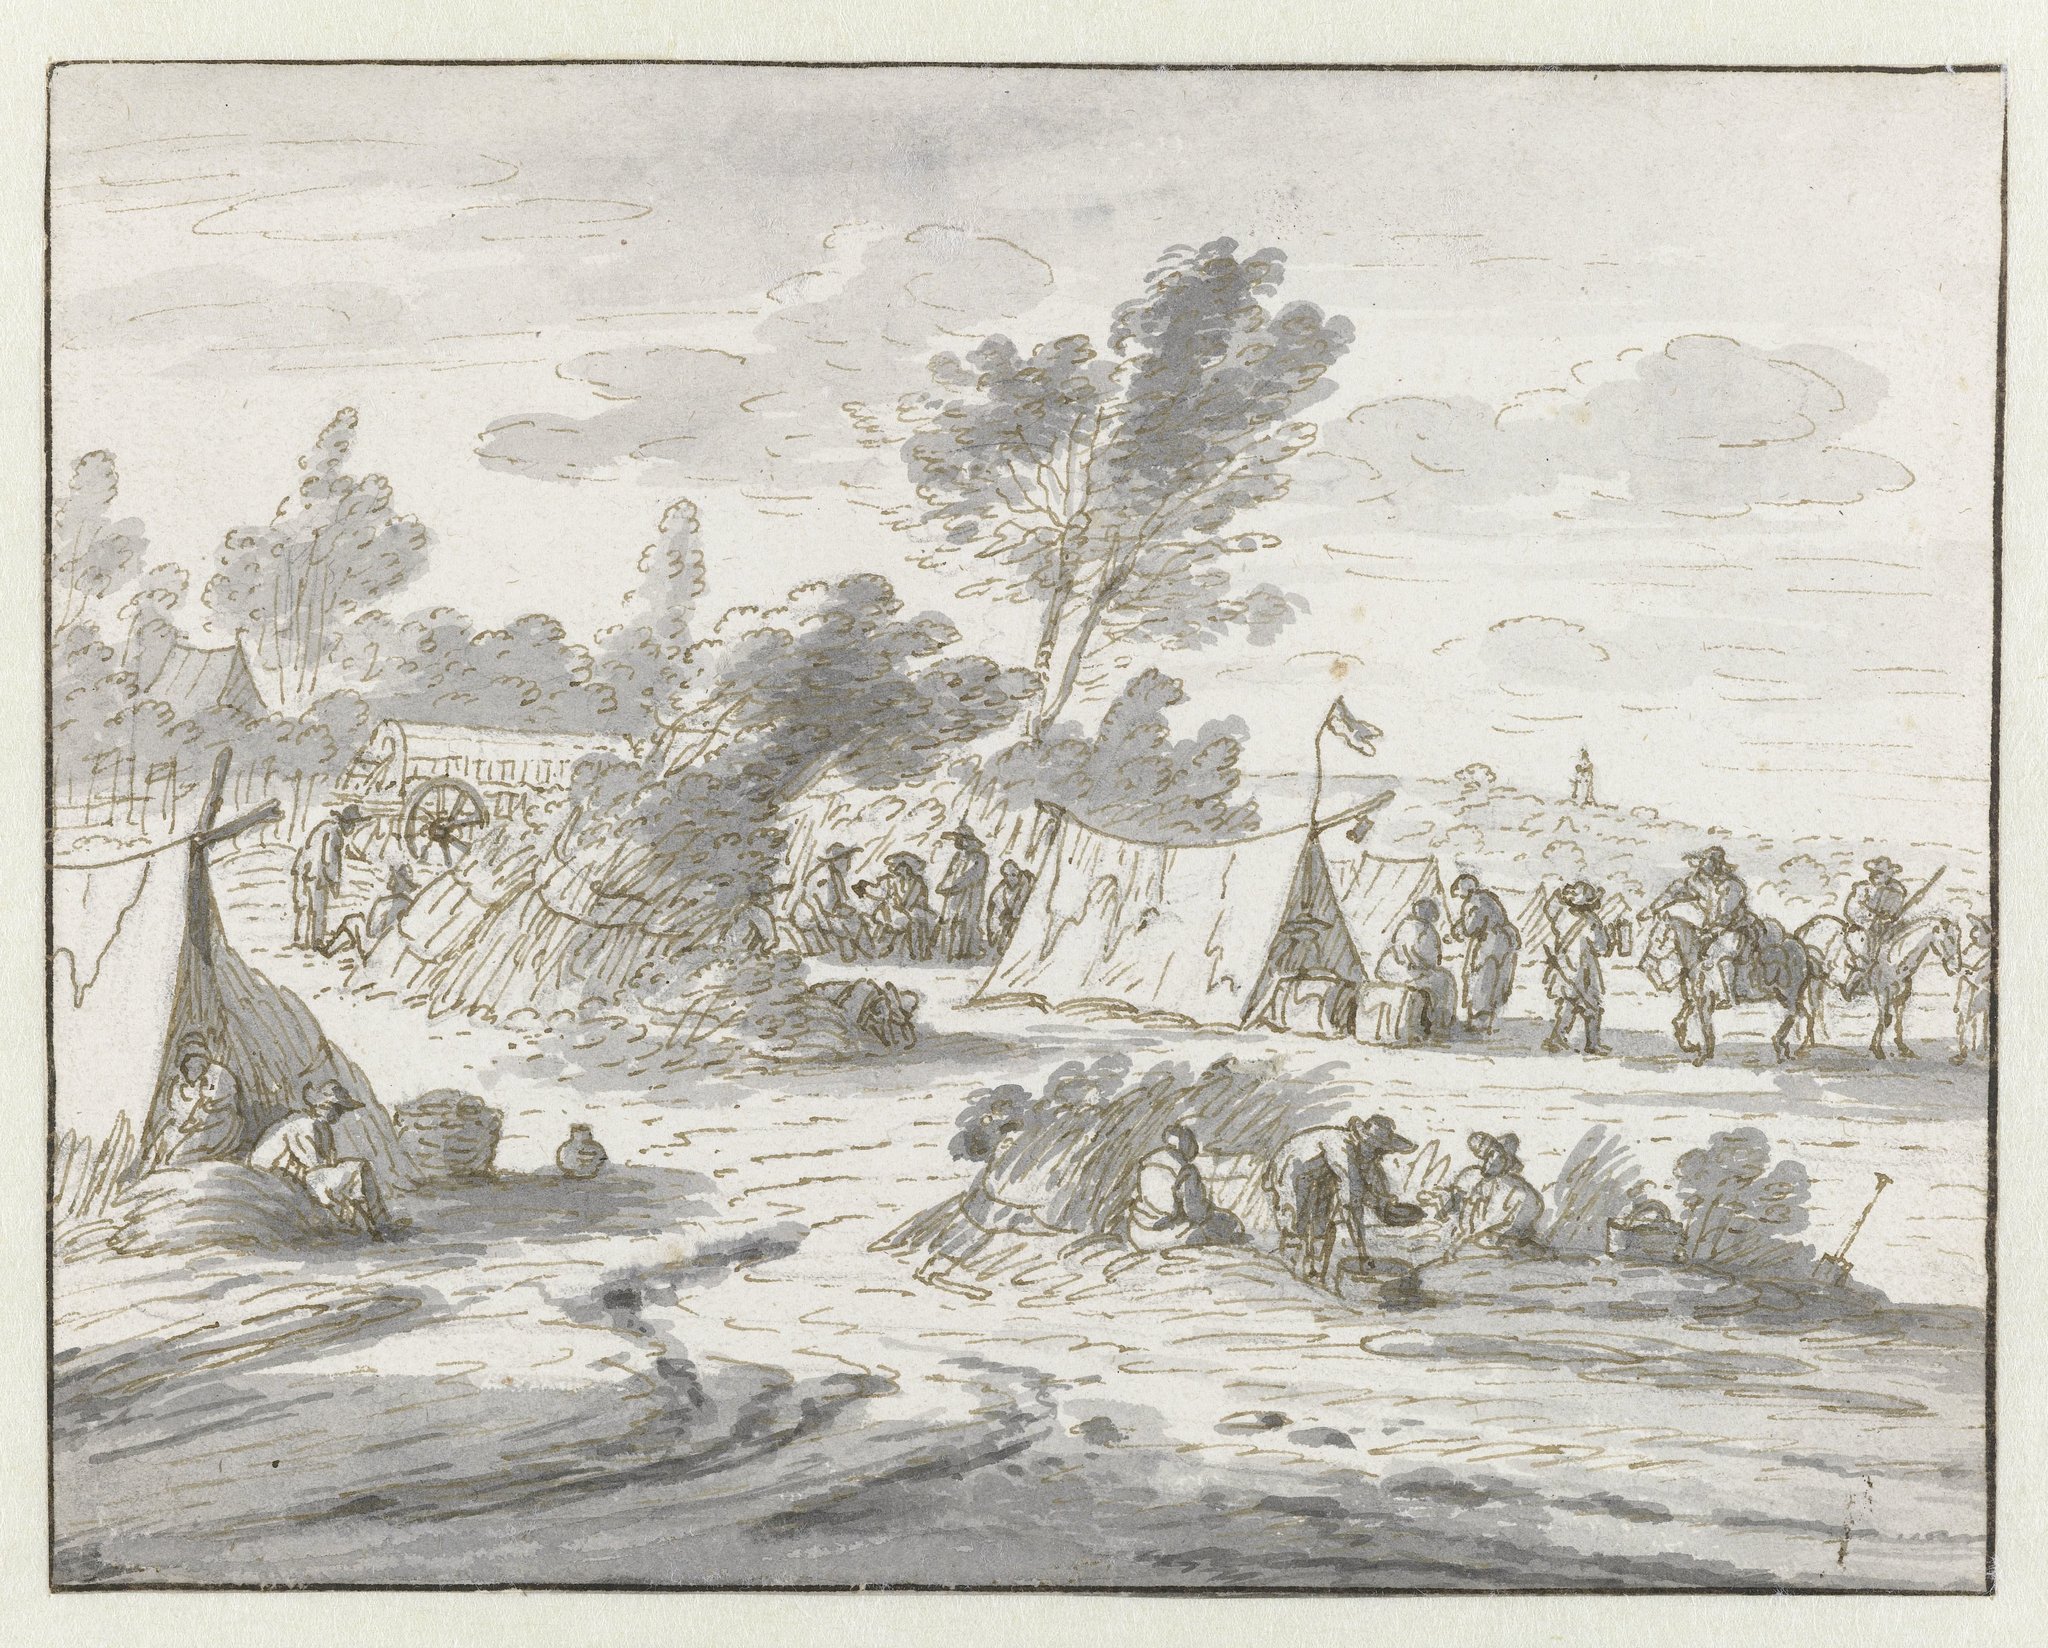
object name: drawing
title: View on an Encampment of the Army of Willem III near Lembeek, Flemish Brabant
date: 1675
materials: ink, paper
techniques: brush, pen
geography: lembeek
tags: william iii (prince of orange and king of england, scotland, and ireland), (military) camp with tents, lembeek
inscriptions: date: ‘16 8/2 75’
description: Kampement van het leger van Willem III bij het dorp Lembeek in Henegouwen, 2 augustus 1675. Soldaten en tenten.